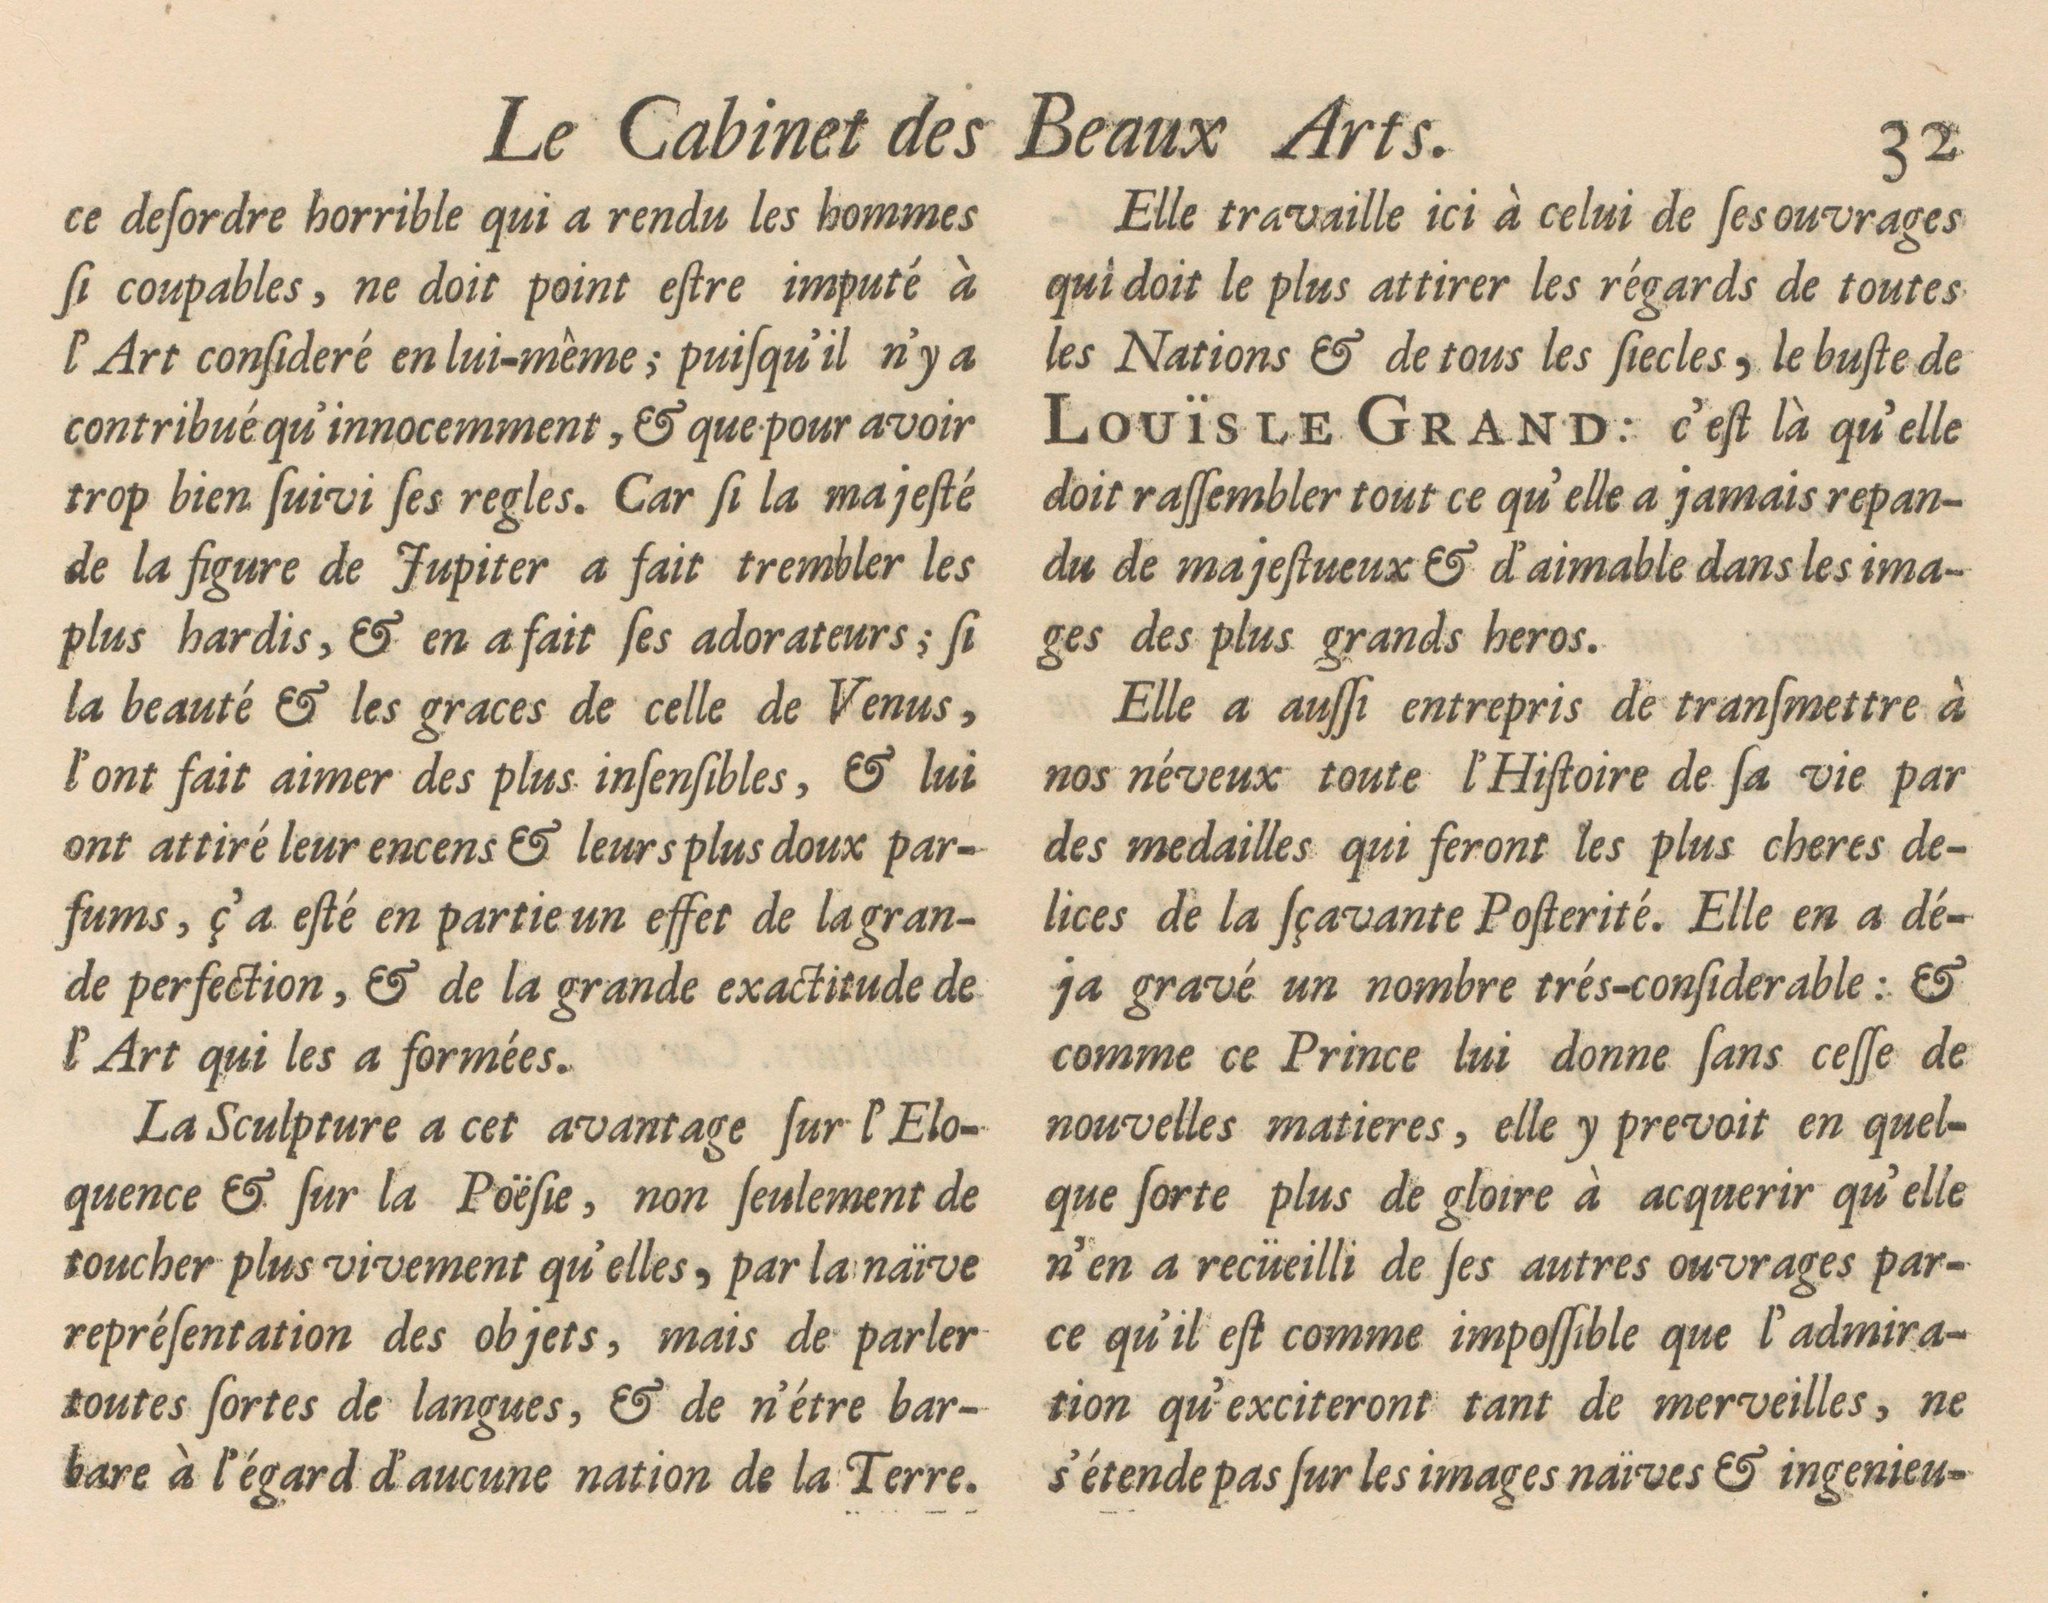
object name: text sheet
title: Tekstblad met verklaring van de prent over Beeldhouwkunst, p. 32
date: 1695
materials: paper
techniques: letterpress printing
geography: paris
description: Verklaring van de prent met voorstelling van Beeldhouwkunst in het Frans. Pagina 32. Tekstblad maakt deel uit van een album.